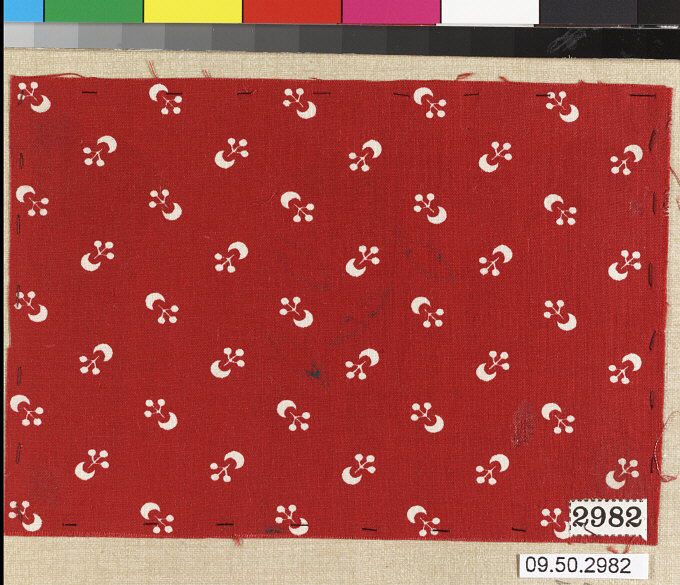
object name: piece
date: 1801-1900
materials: cotton